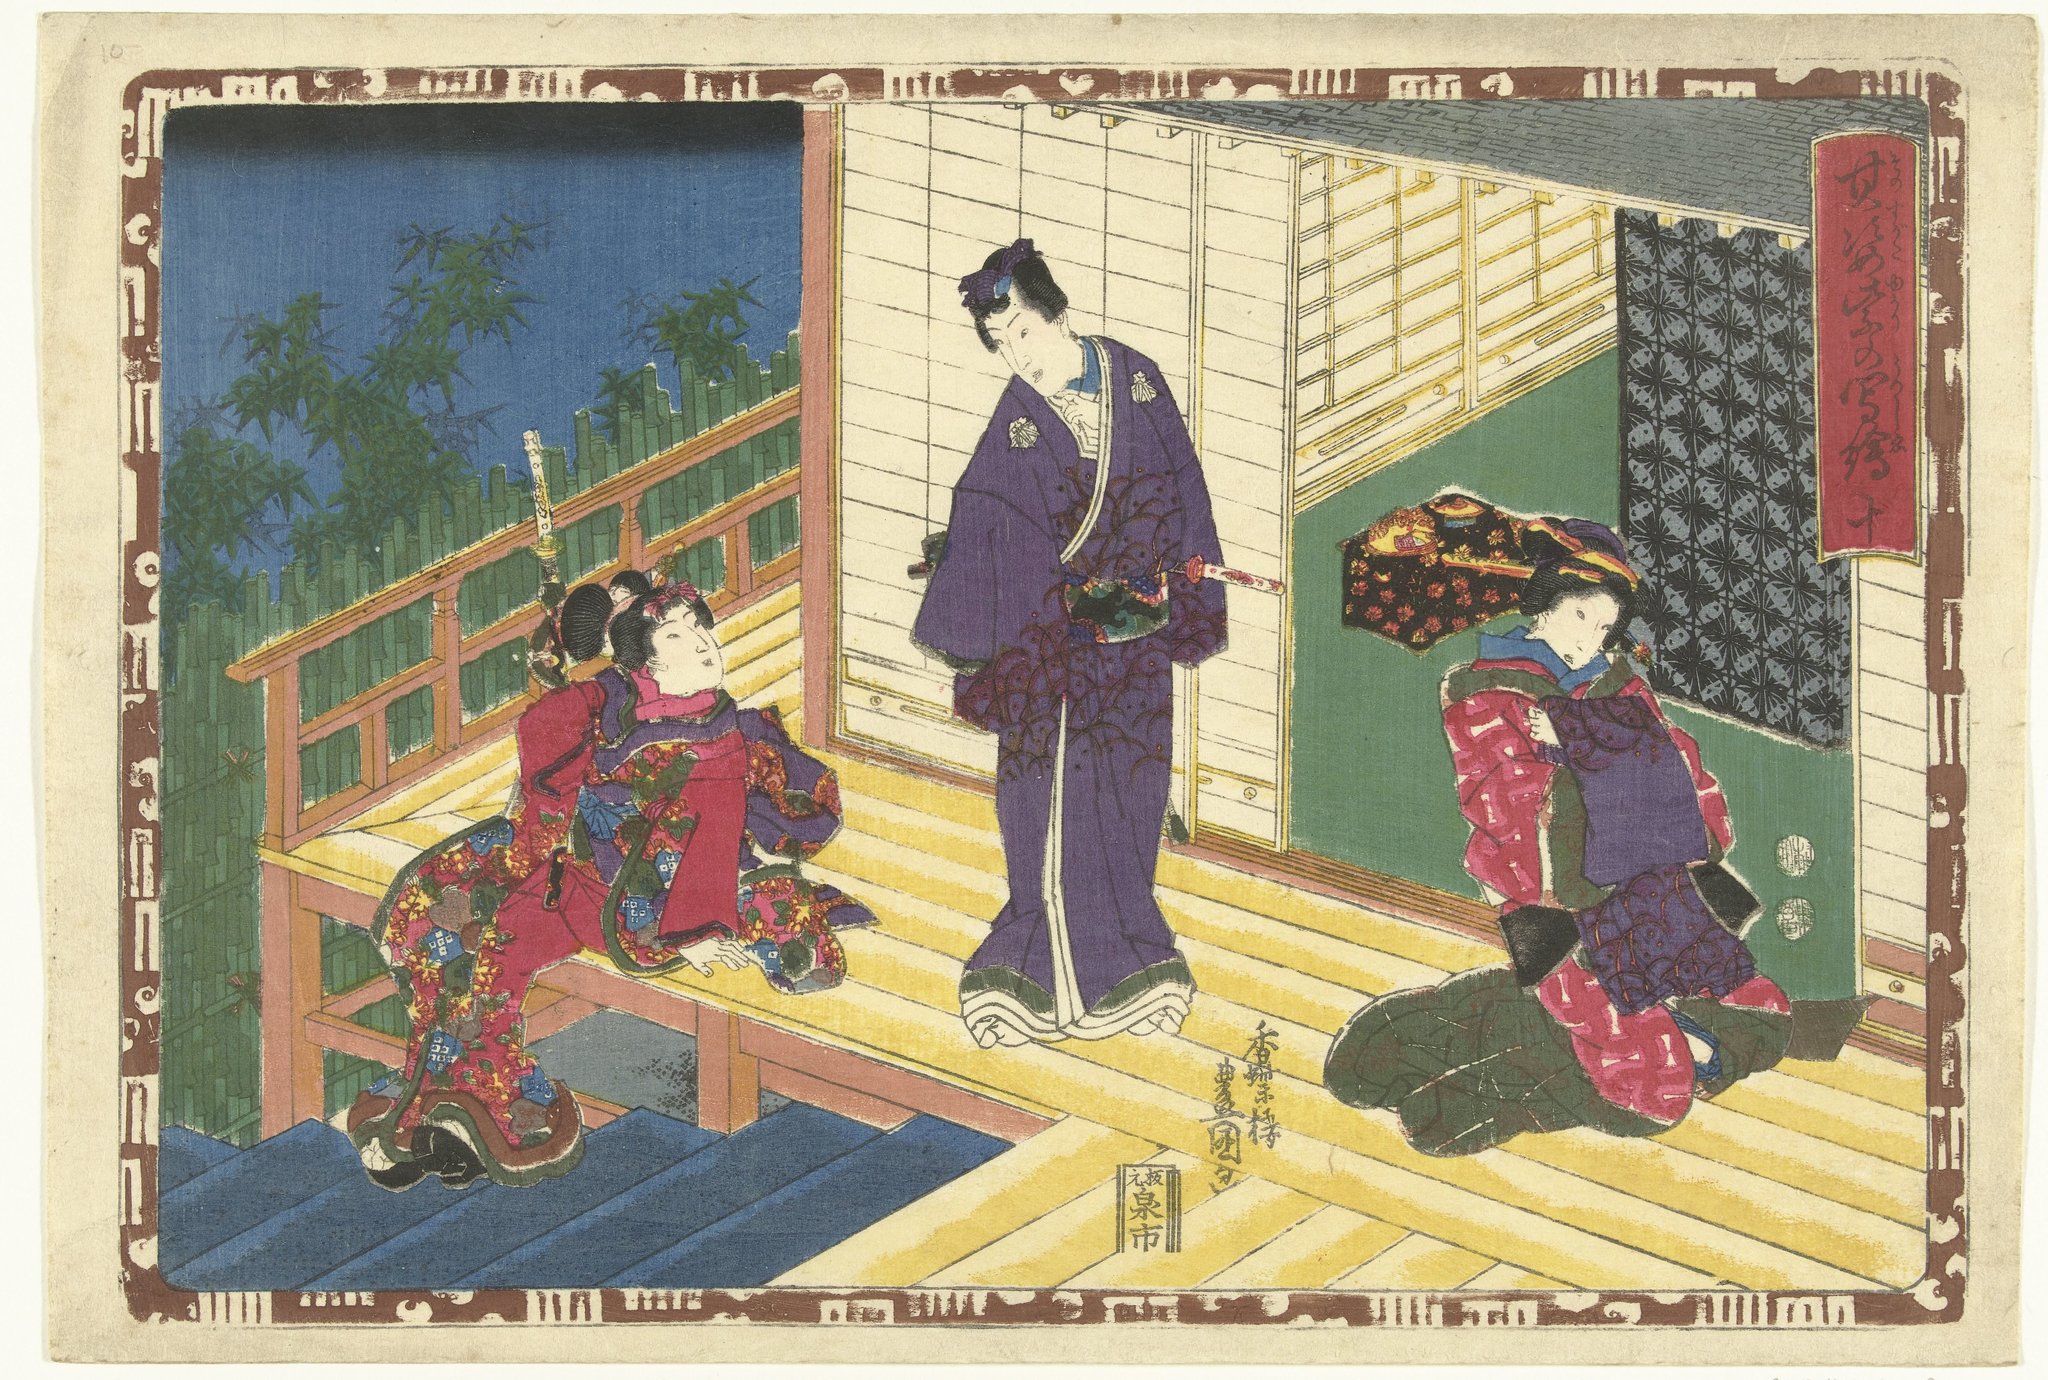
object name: print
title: Sono sugata Hikaru no utsushi-e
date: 1847-1850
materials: paper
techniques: woodcut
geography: tokyo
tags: prince, loggia, verandah, porch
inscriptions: collector's mark: Lugt 2228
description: Prins Genji op een veranda met twee vrouwen. Voorstelling omsloten door bruine rand waarin Genji emblemen.